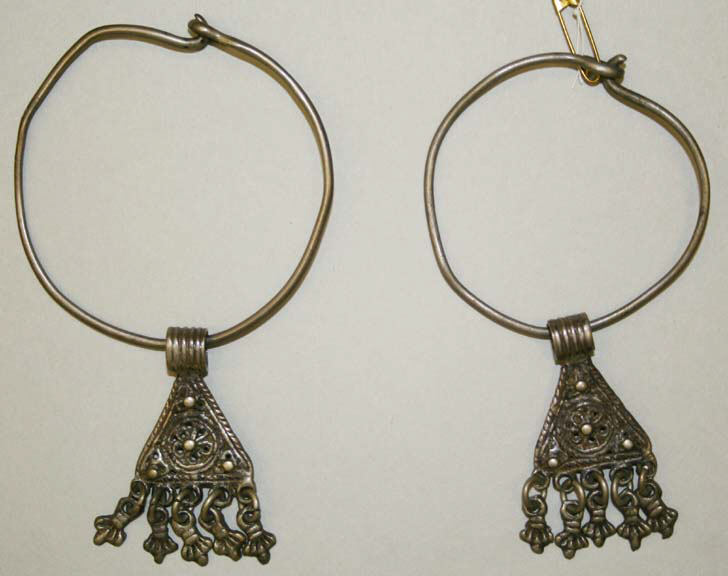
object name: earring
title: Earrings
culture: spanish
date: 1867-1933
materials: silver